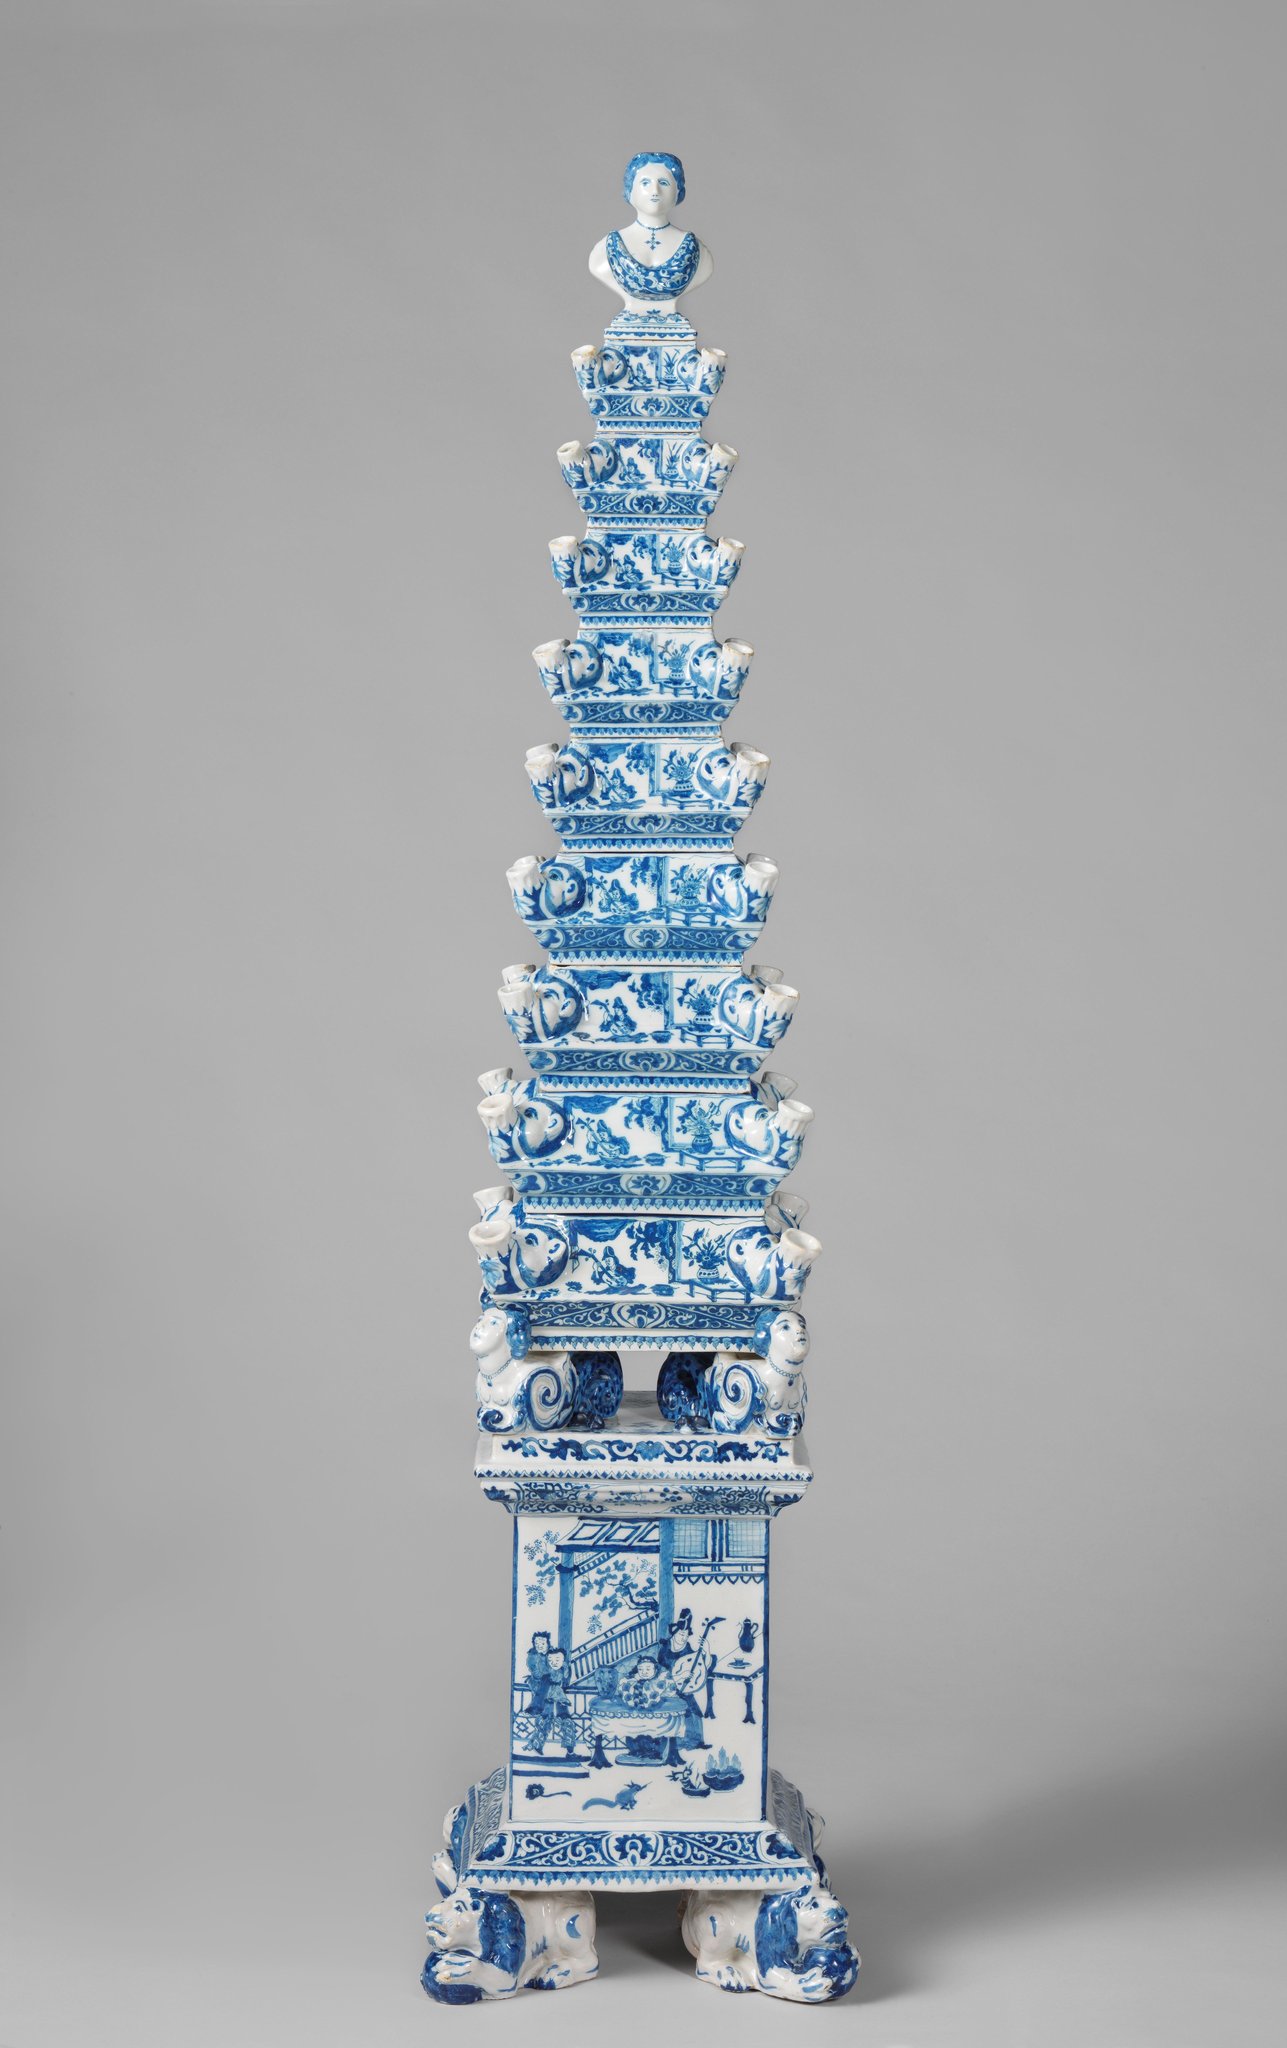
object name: bloempiramide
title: Flower pyramid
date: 2003-2004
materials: earthenware, glaze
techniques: painted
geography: makkum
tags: flowers, one person playing string instrument (plucked), beasts of prey, predatory animals: lion, chest, bust - aa - female human figure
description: Segment van bloempiramide van faience, blauw beschilderd in de glazuur. Musicerende figuren en figuren met schaal.